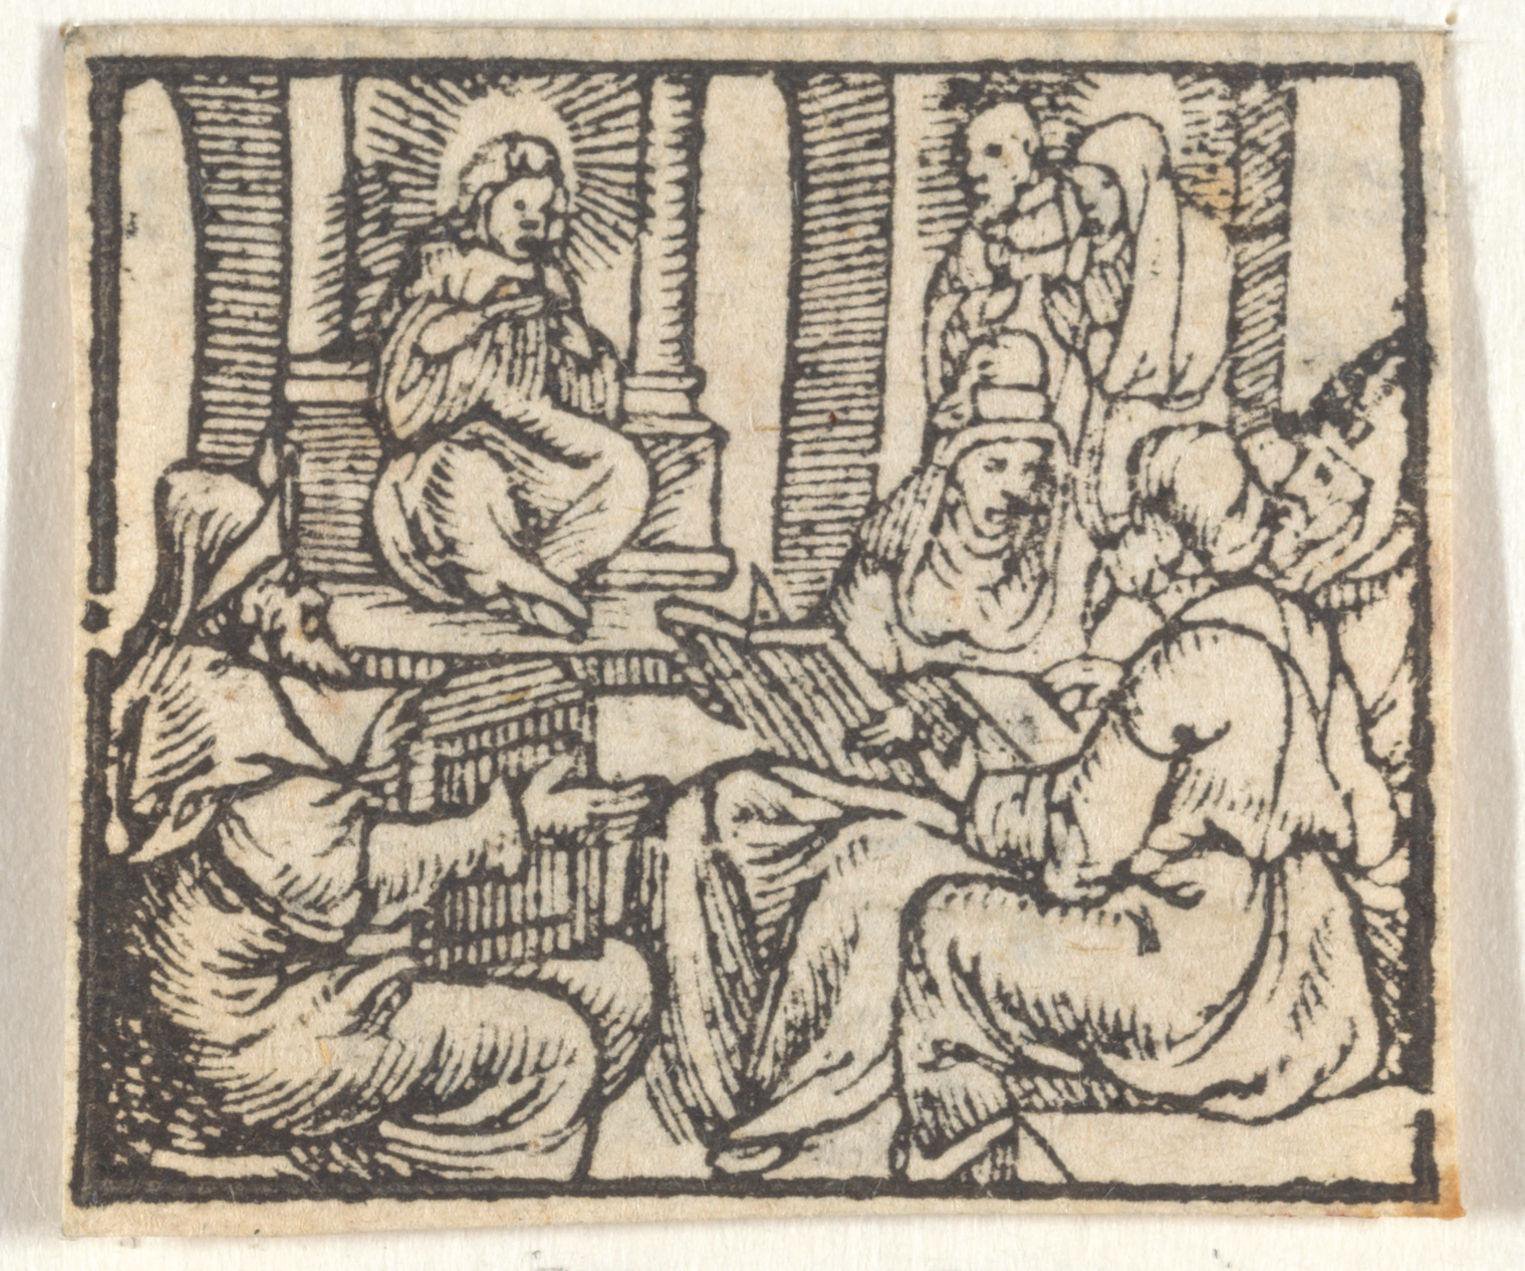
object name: print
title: Twaalfjarige Christus in de tempel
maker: Anonymous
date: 1600-1699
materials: paper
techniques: letterpress printing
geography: netherlands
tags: christ's dispute with the doctors in the temple; he counts his arguments on his fingers, christ found by his parents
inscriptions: collector's mark: Lugt 240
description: In de tempel zit Christus tussen de schriftgeleerden en legt hen de schrift uit. Jozef en Maria lopen de tempel binnen.